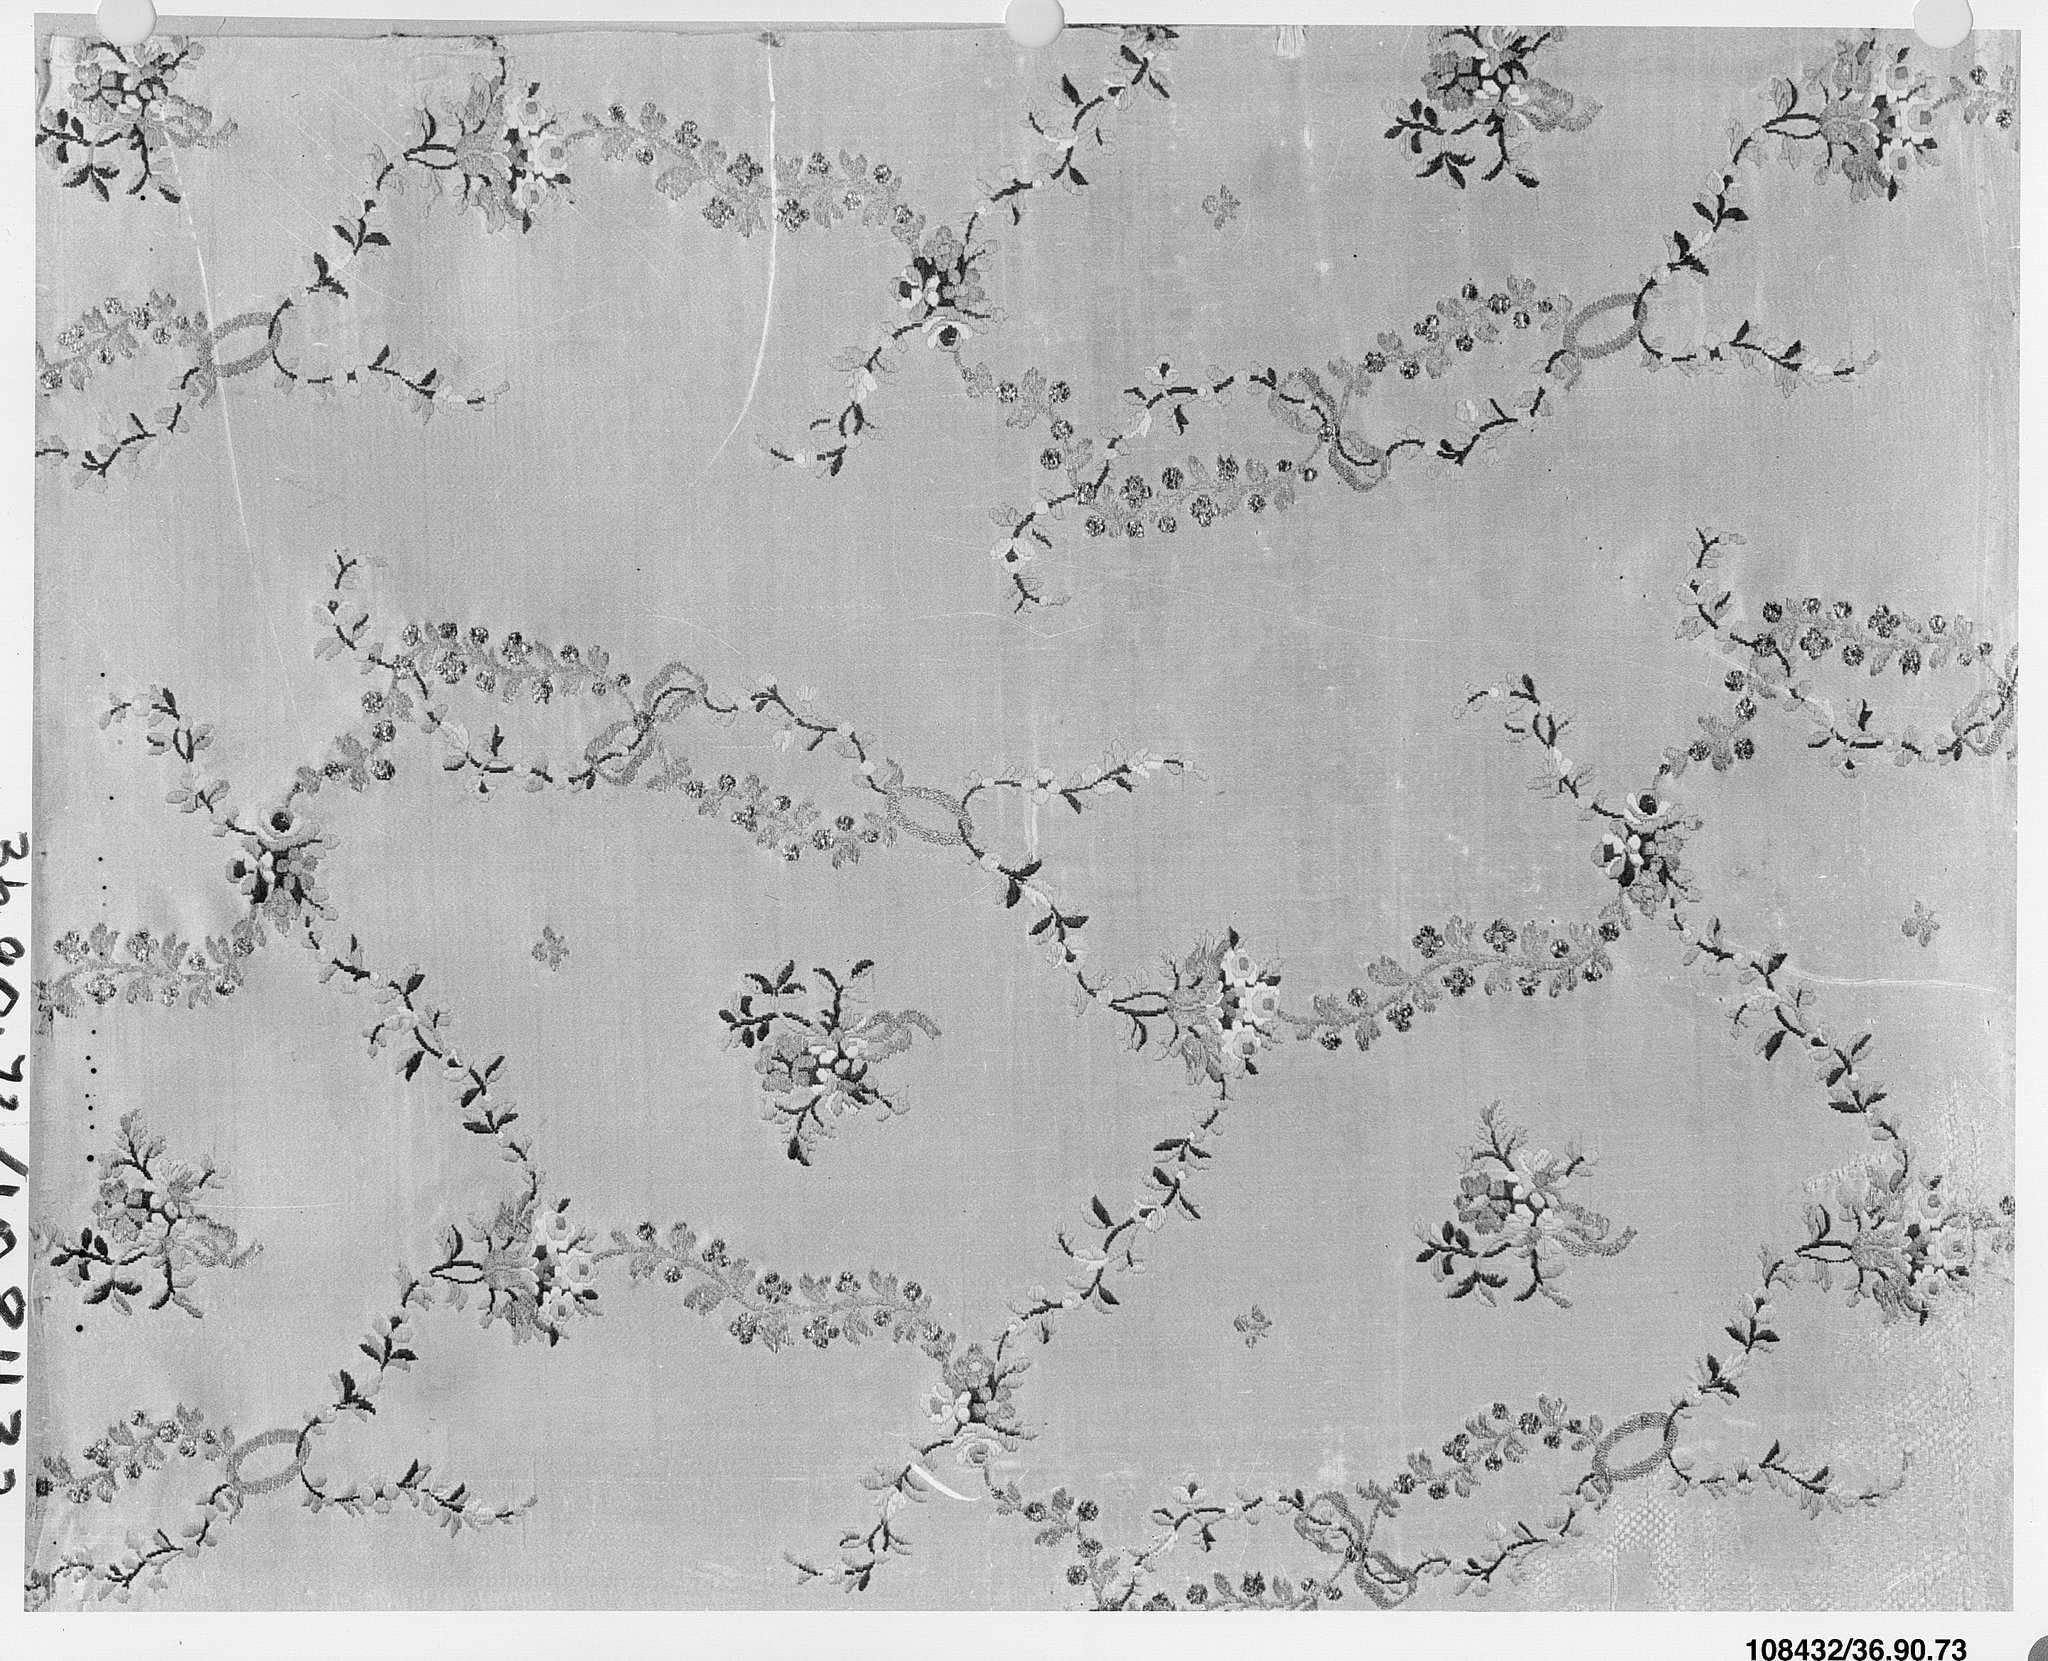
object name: piece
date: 1760-1770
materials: metal thread, silk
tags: flowers